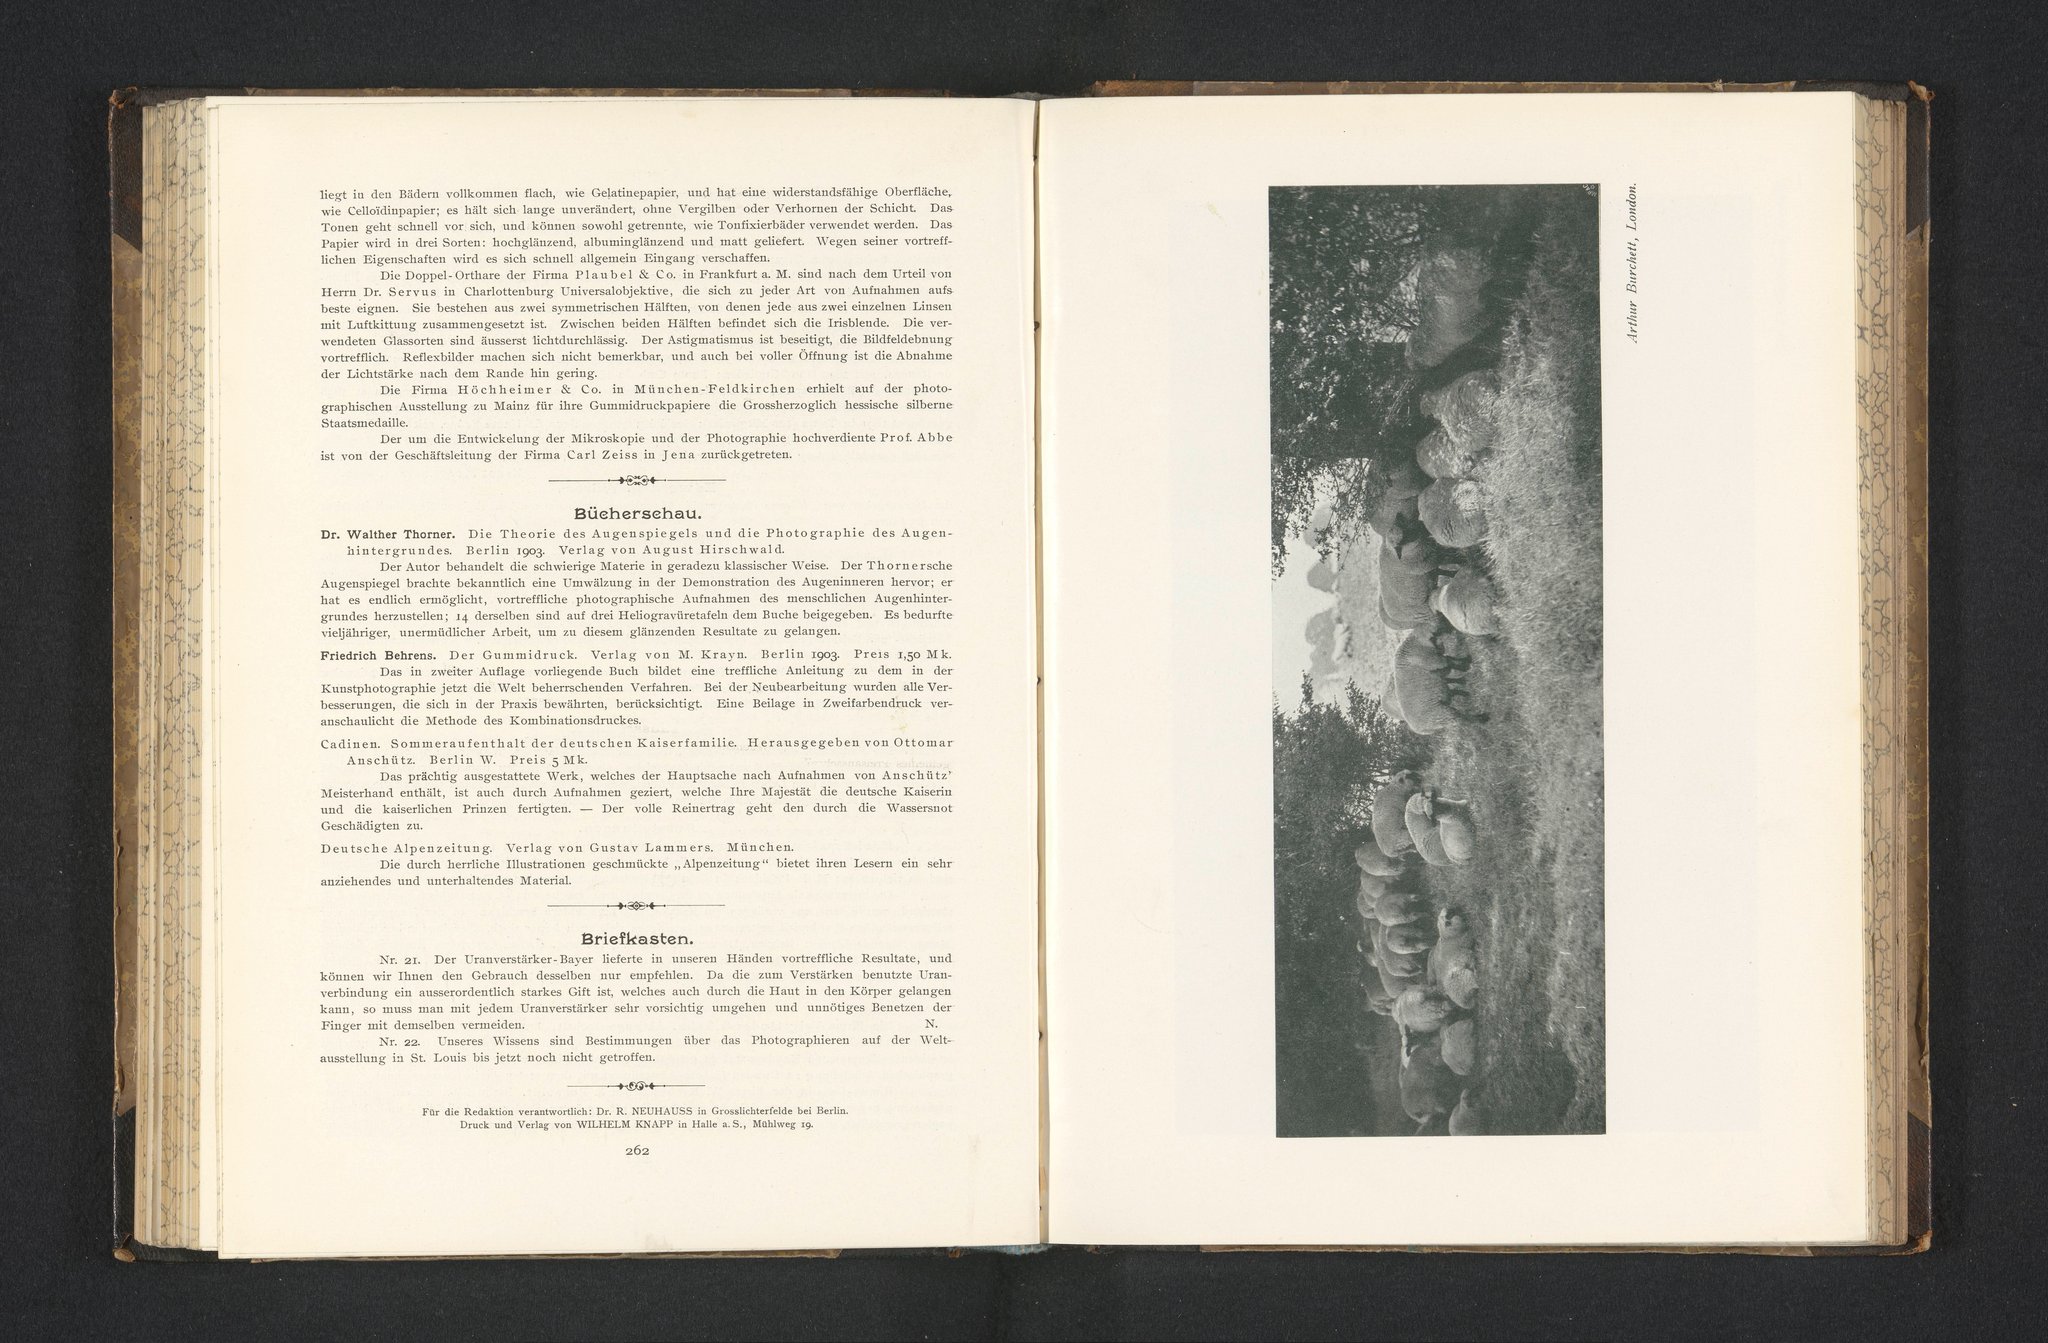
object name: photomechanical print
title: Kudde schapen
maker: arthur burchett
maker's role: painter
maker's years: 1853-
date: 1898-1903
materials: paper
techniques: autotype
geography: berlin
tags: sheep, herd, flock